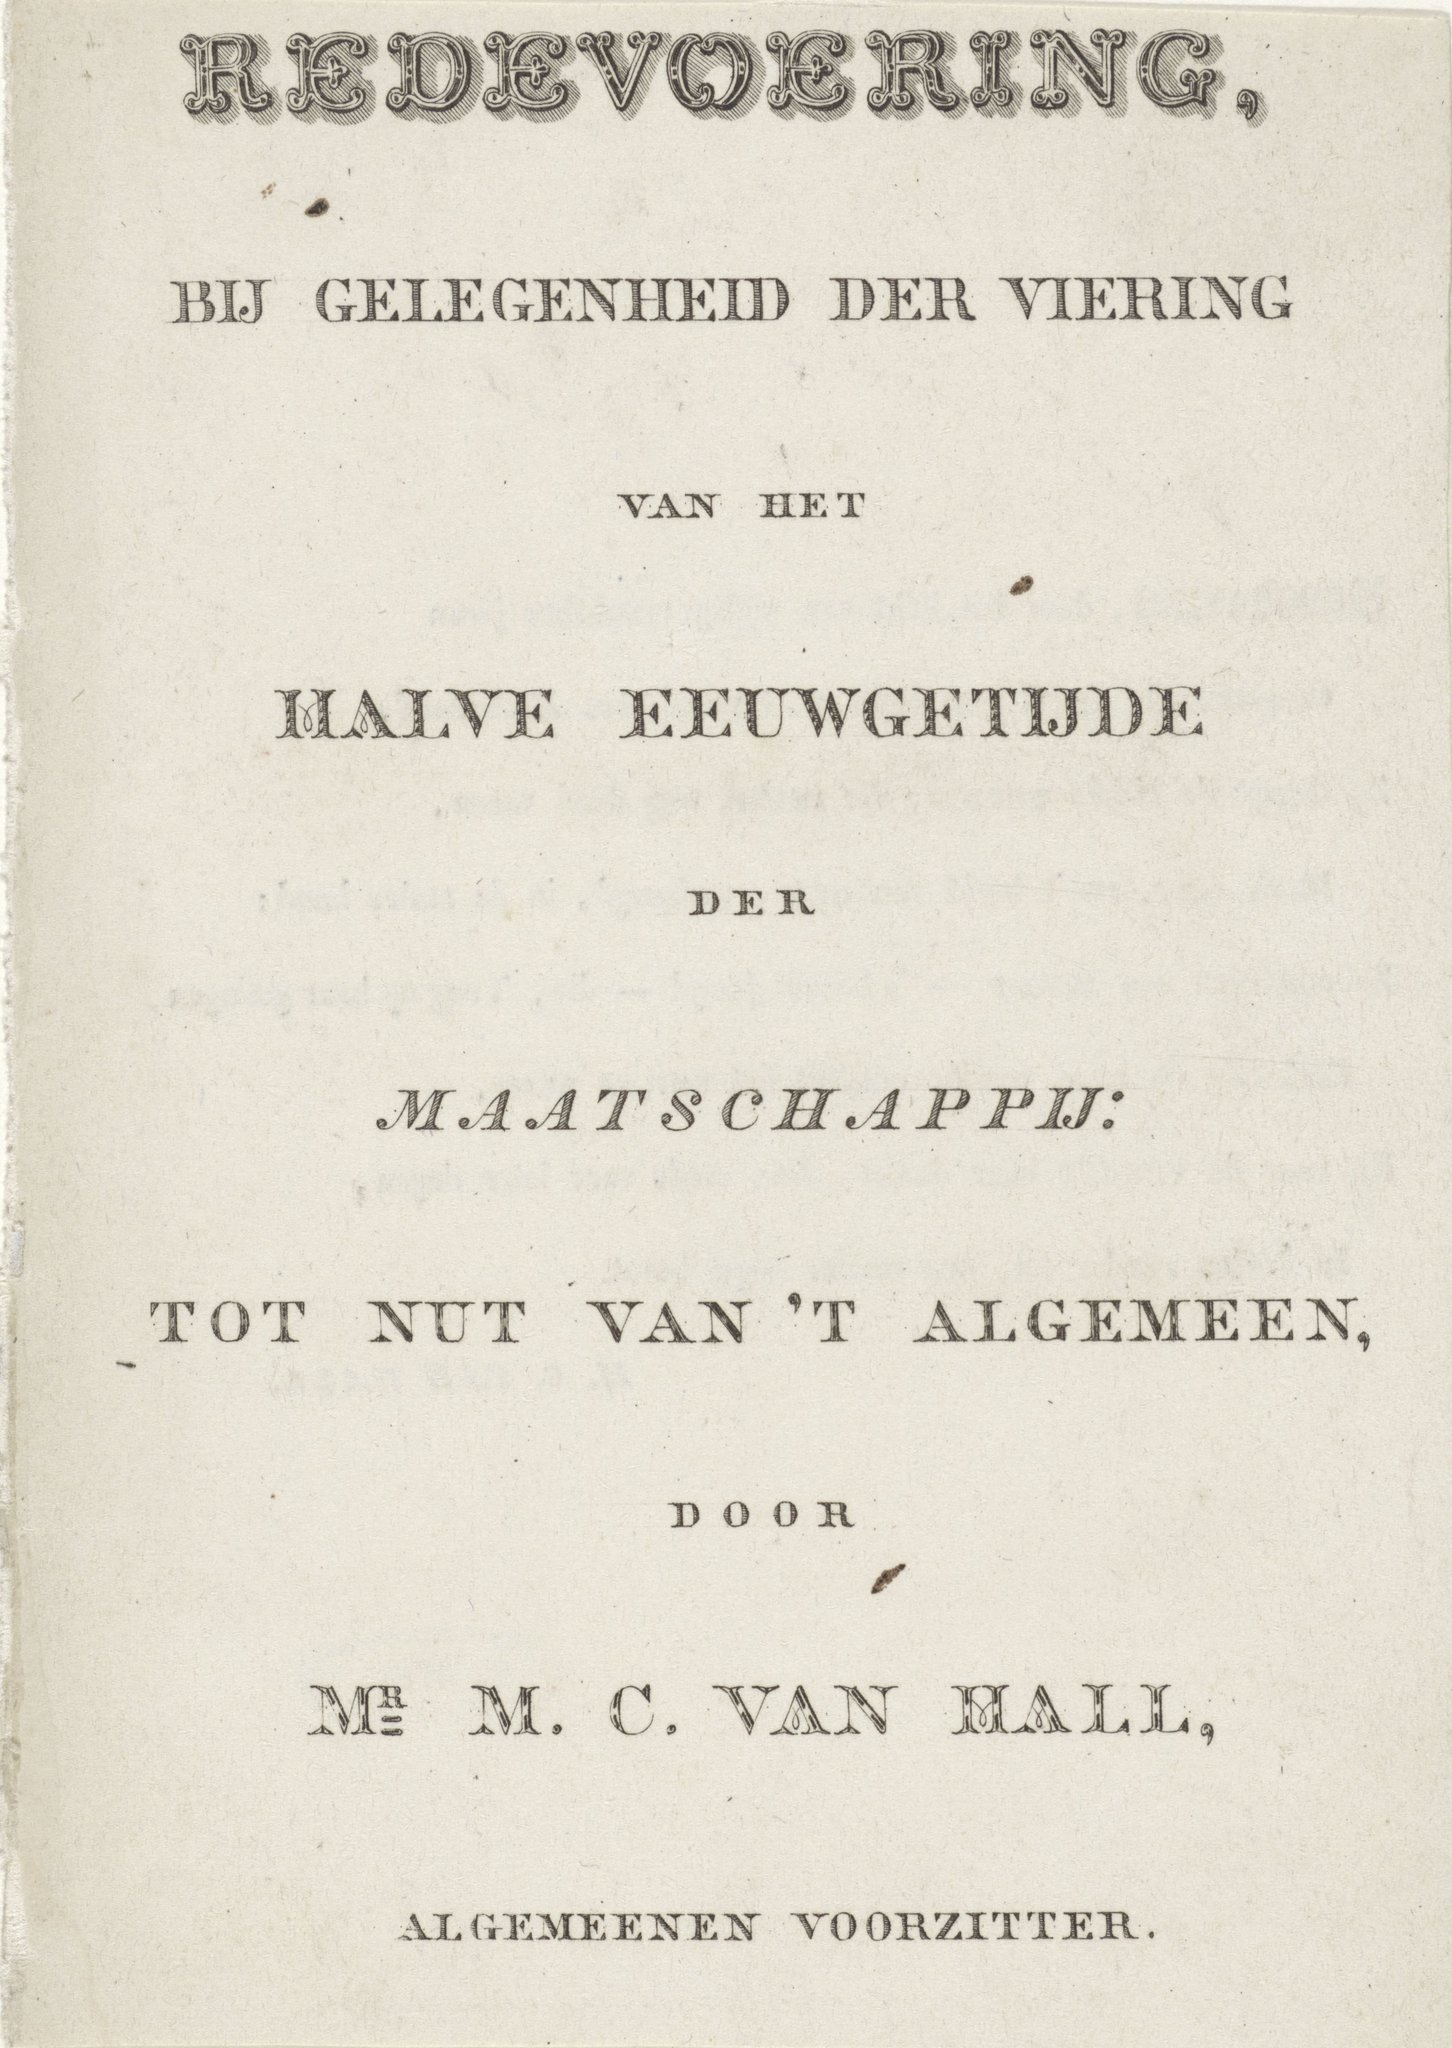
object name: text sheet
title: Redevoering, bij gelegenheid der viering van het halve eeuwgetijde der maatschappij: tot nut van 't algemeen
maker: Anonymous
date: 1834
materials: paper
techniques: etching, letterpress printing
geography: netherlands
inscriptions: collector's mark: Lugt 2228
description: Titelpagina voor: Hall. M.C. van. Redevoering, bij gelegenheid der viering van het halve eeuwgetijde der maatschappij: tot nut van 't algemeen. 1834.